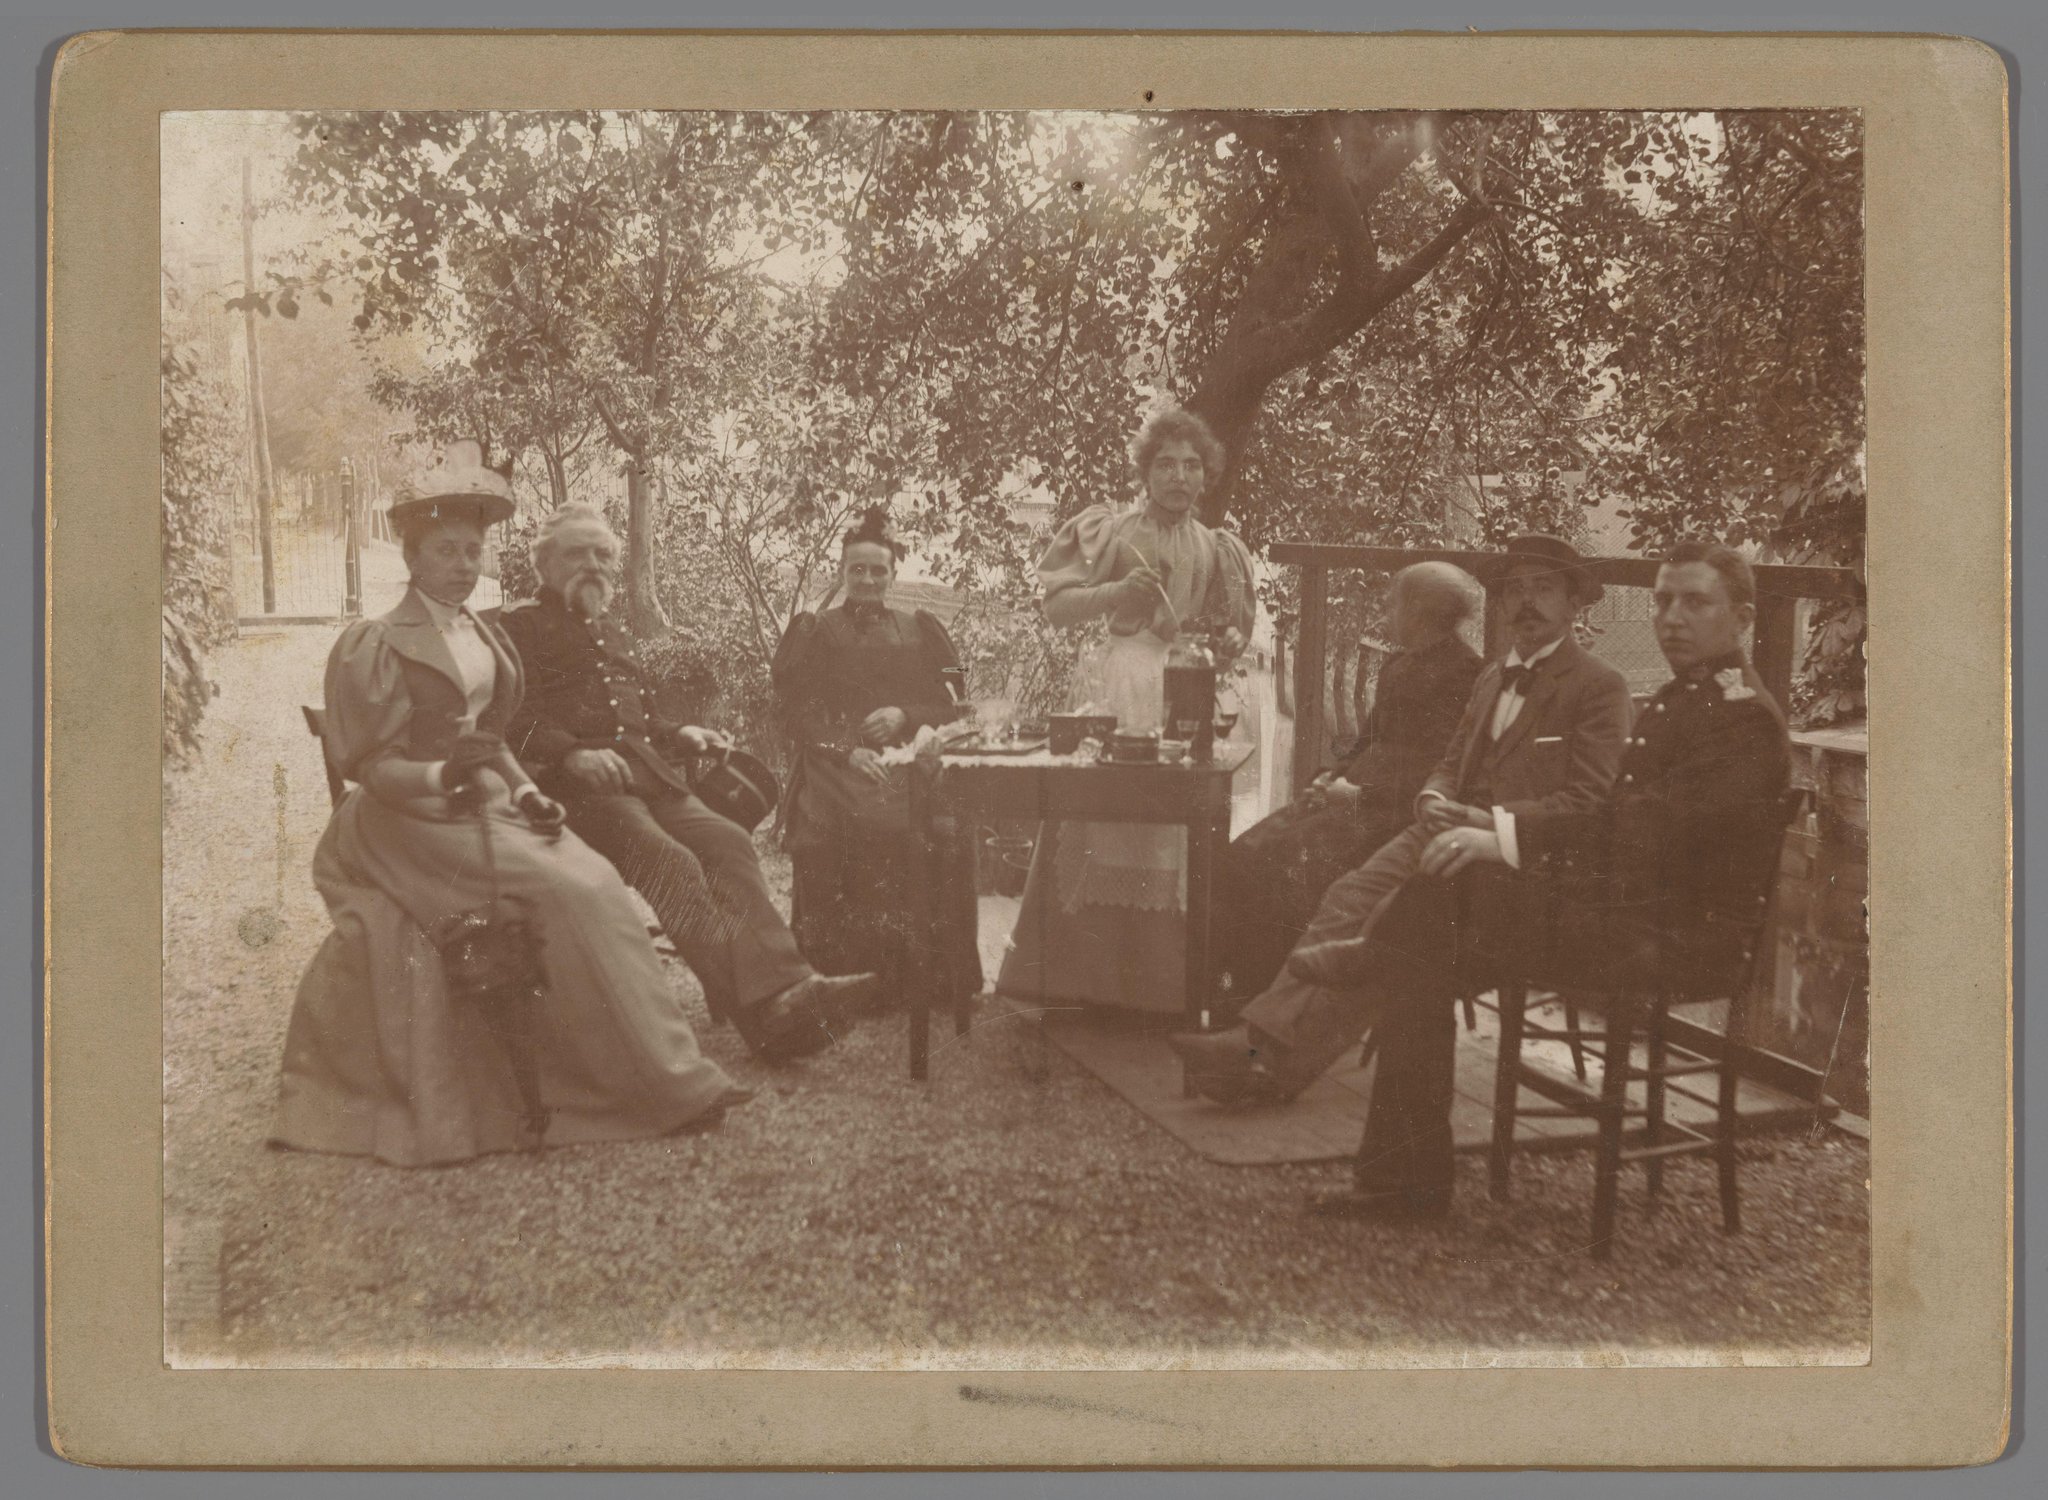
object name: photograph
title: Groepsportret van vier onbekende vrouwen en drie mannen rond een tafel in een tuin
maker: Anonymous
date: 1890-1910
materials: paper, cardboard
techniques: gelatin silver print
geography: netherlands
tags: anonymous historical persons portrayed in a group, in a group-portrait